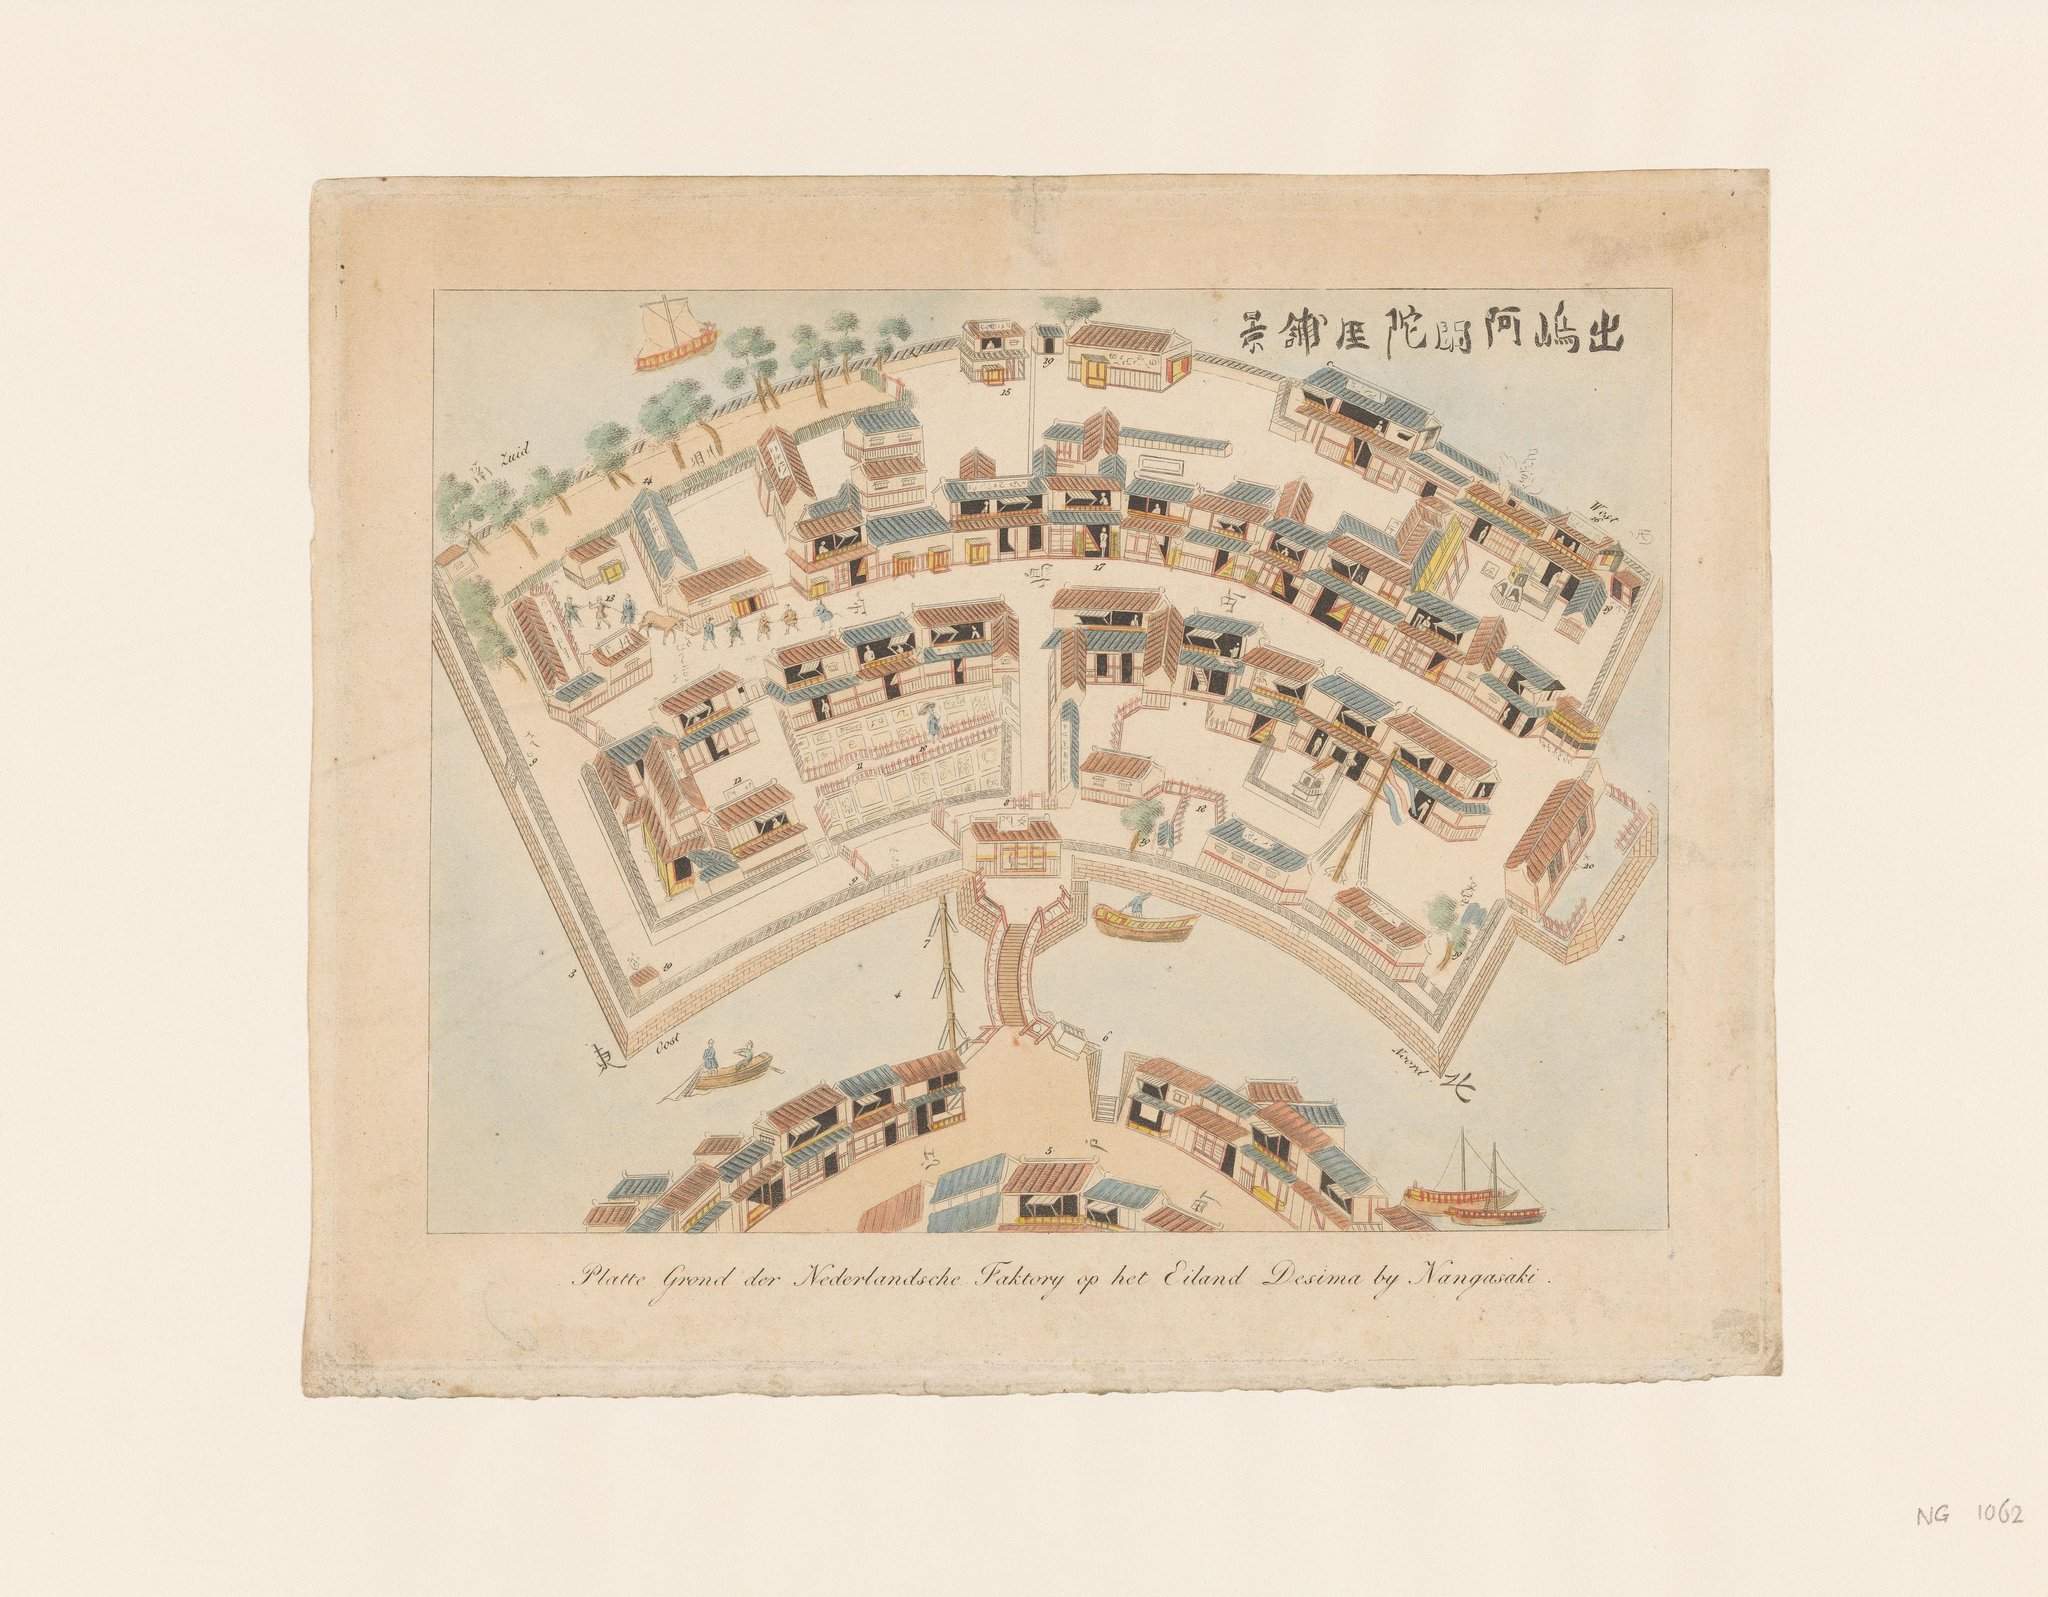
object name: print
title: Platte Grond der Nederlandsche Faktorij op het eiland Desima bij Nangasaki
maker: Anonymous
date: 1825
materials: paper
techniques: colour, engraving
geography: netherlands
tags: maps of cities, japan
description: Gebruikt als illustratie in: Isaac Titsingh, Bijzonderheden over Japan, dl II. Wed. J. Allart: Den Haag, 1825. Nederlandse gravure naar een Japanse houtsnede gepubliceerd in 1780 door de uitgever Toshimaya Bunjiemon te Nagasaki.